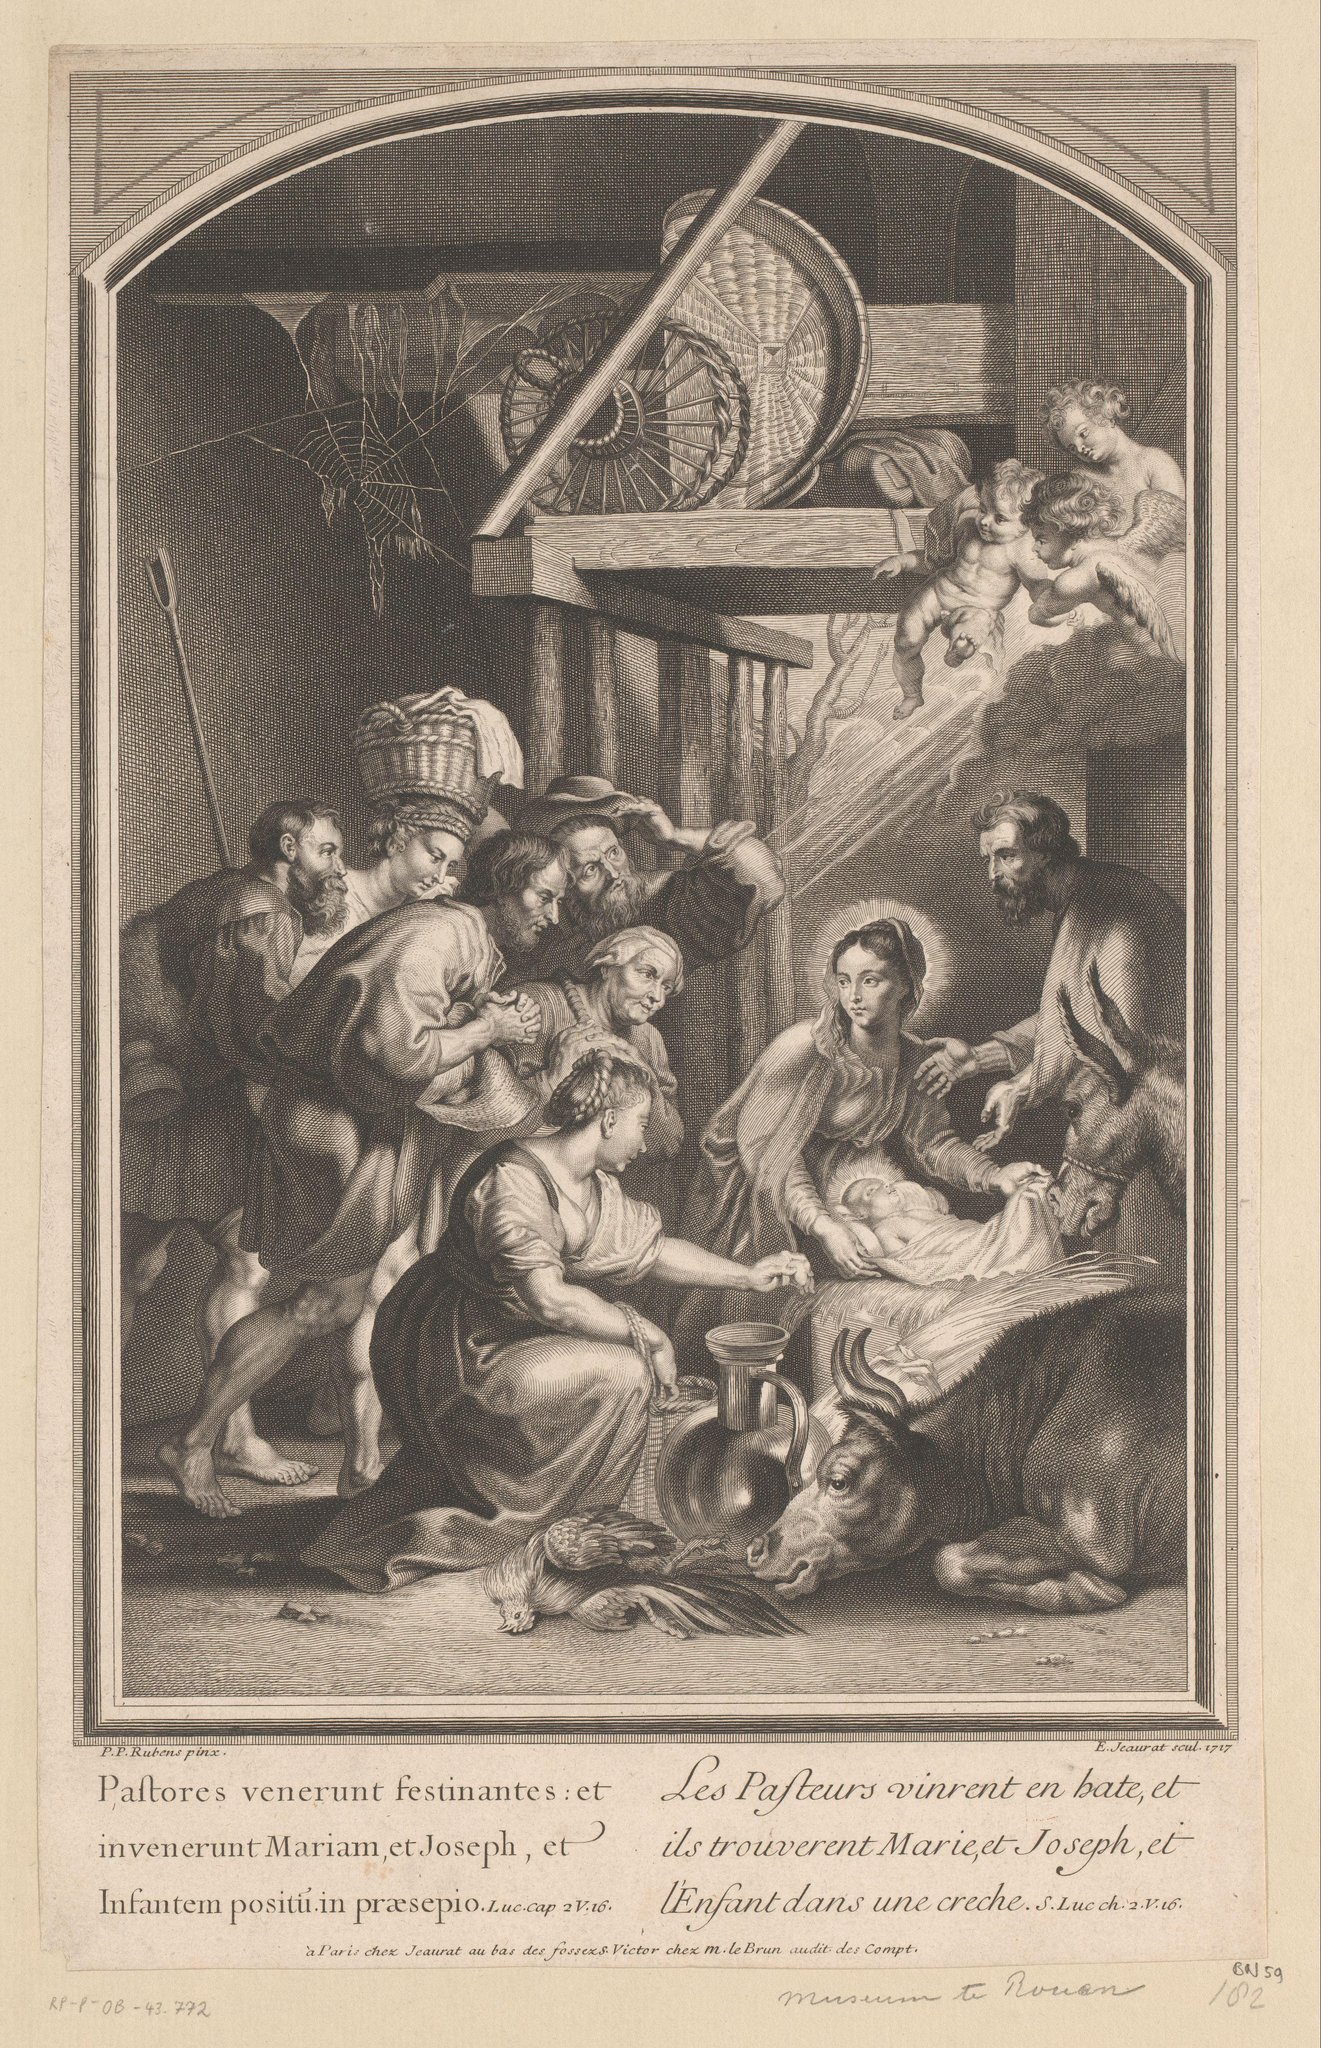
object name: print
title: Geboorte van Christus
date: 1717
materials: paper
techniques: engraving, etching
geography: paris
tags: adoration of the christ-child ~ christ's birth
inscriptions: collector's mark: Lugt 240